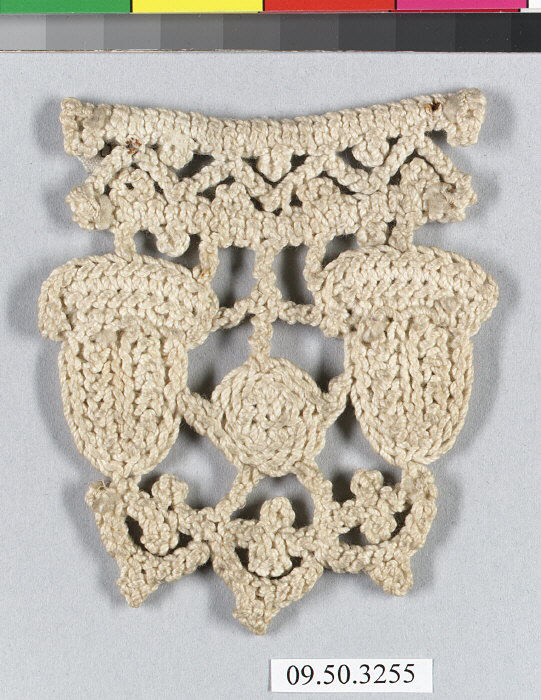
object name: sample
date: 1801-1900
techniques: crochet